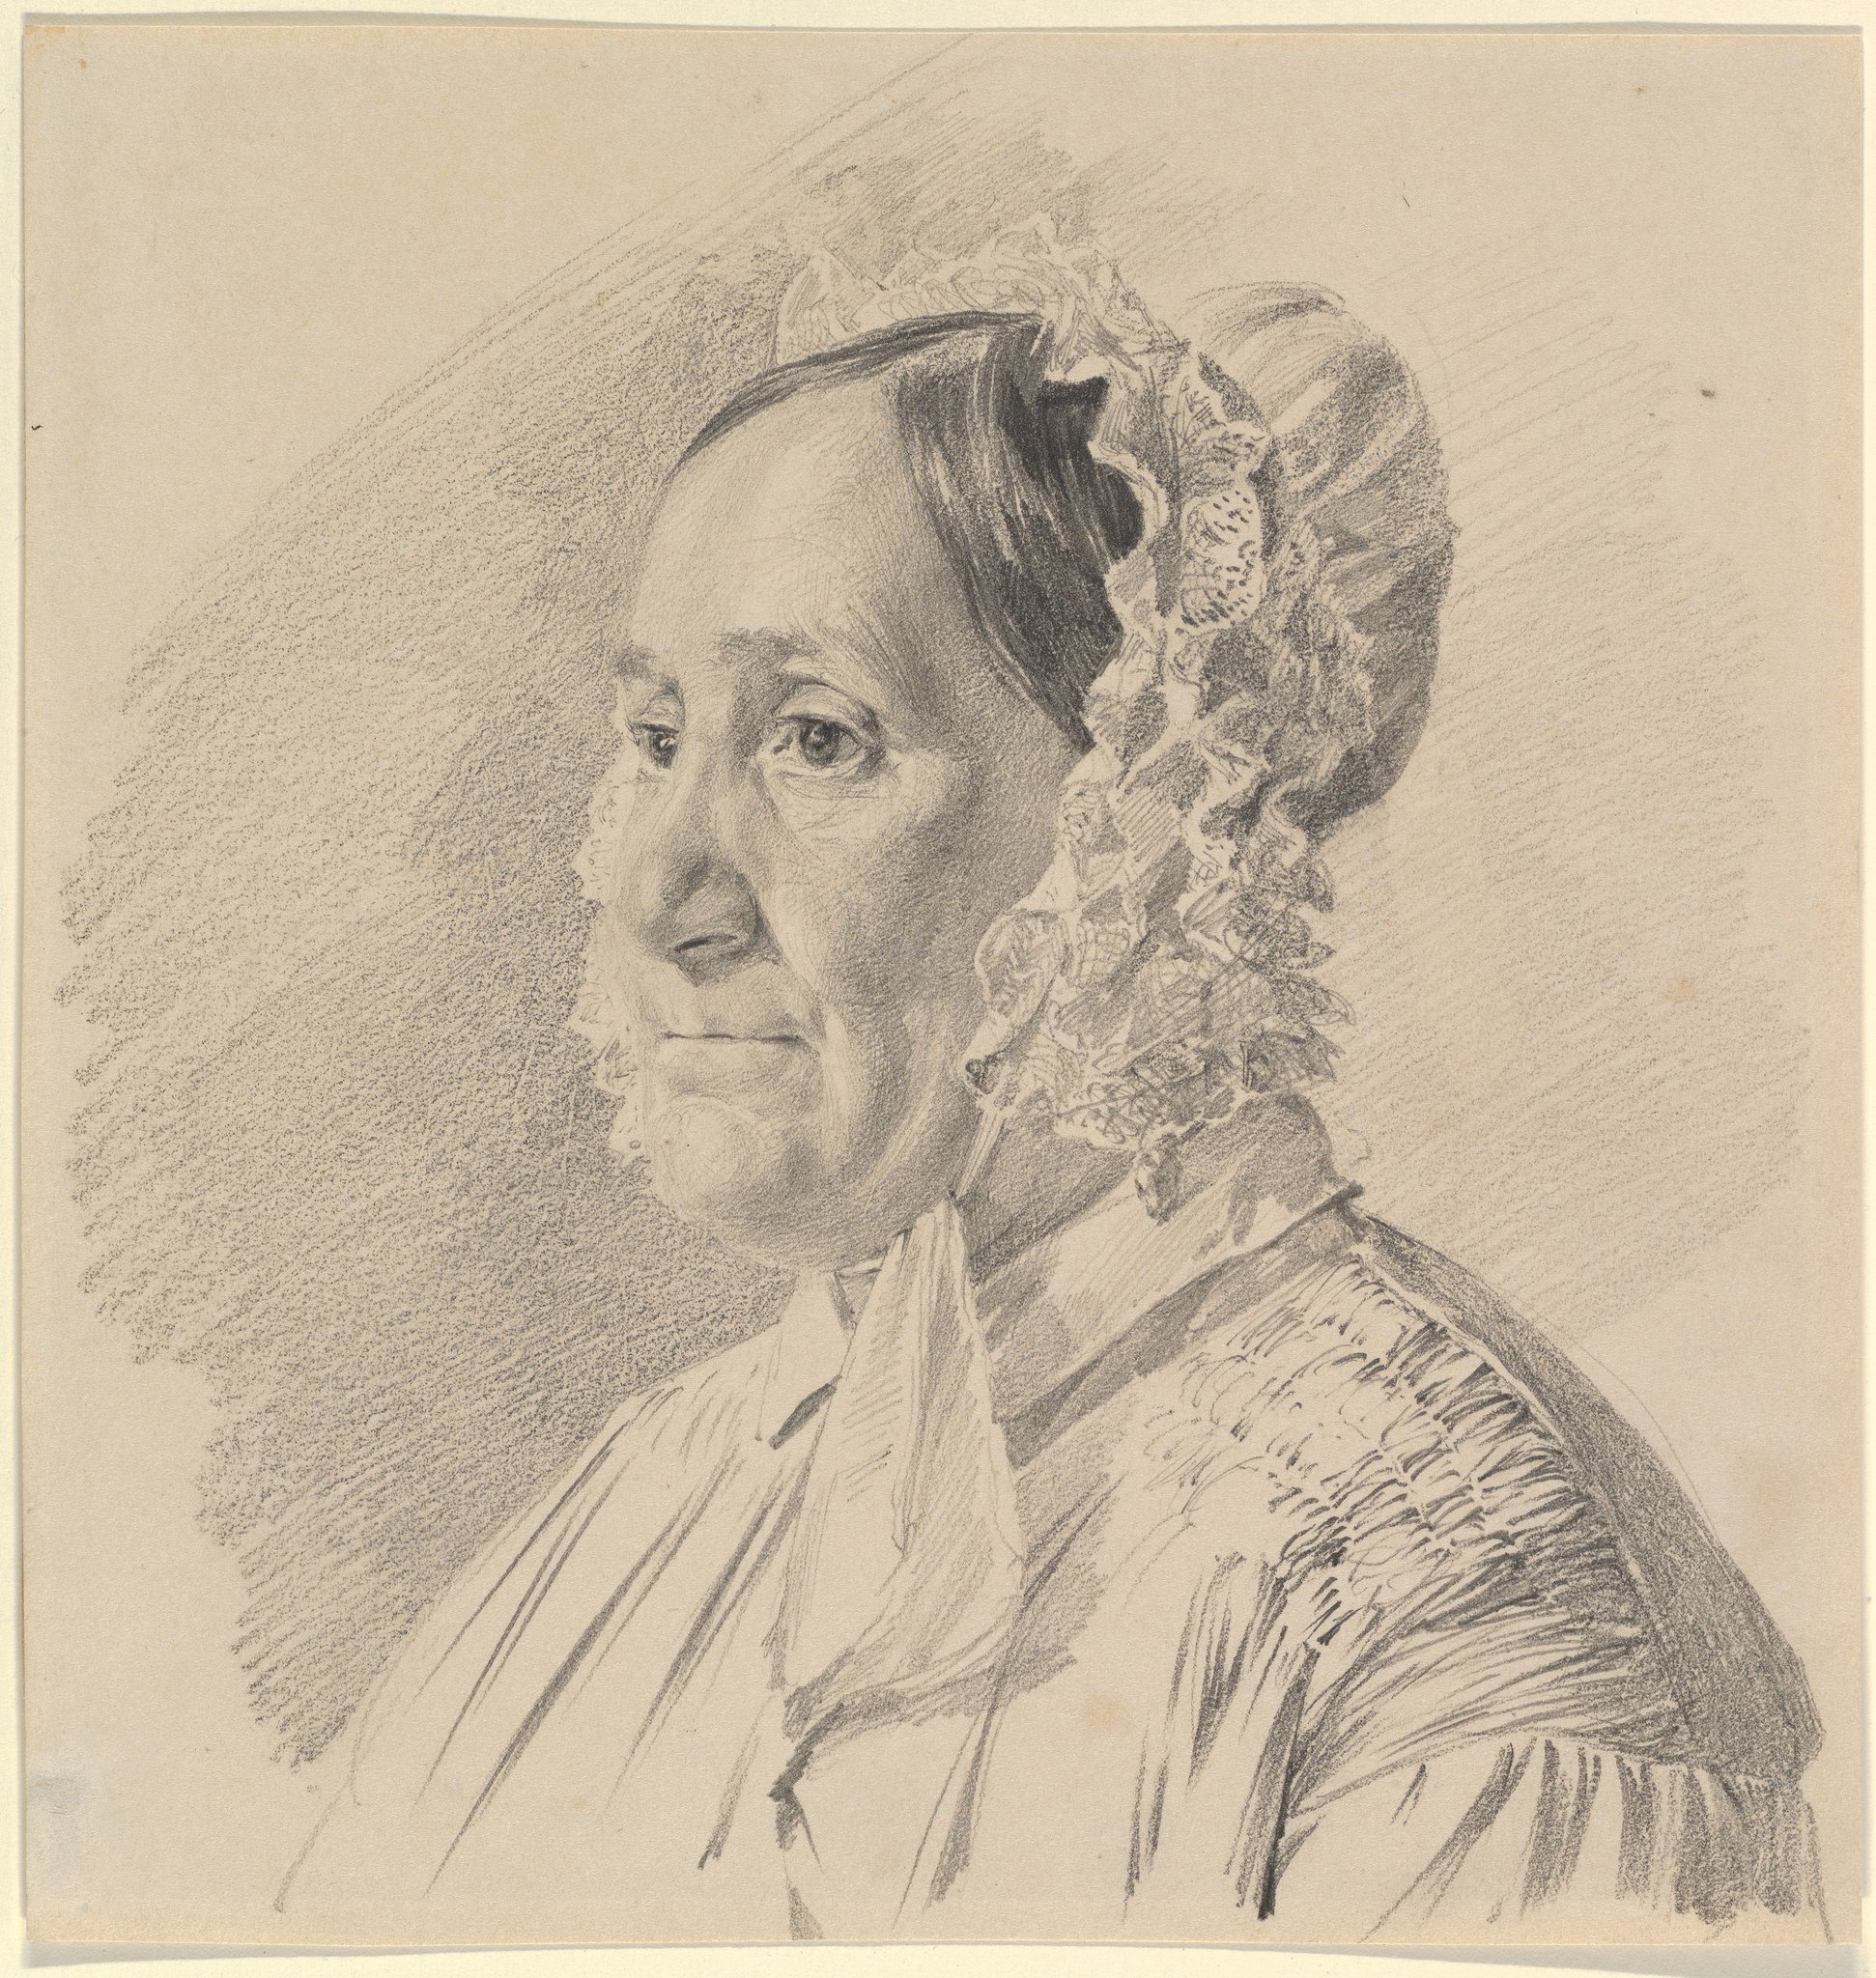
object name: drawing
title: Portrait of a Woman in a Lace Bonnet, in three-quarter profile to the left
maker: ferdinand georg waldmüller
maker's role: artist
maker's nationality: austrian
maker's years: 1793-1865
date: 1834-1866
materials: graphite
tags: portraits,women